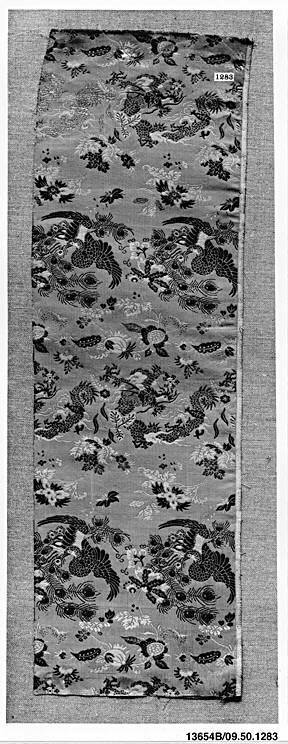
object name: piece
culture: japanese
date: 1801-1900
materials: silk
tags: birds